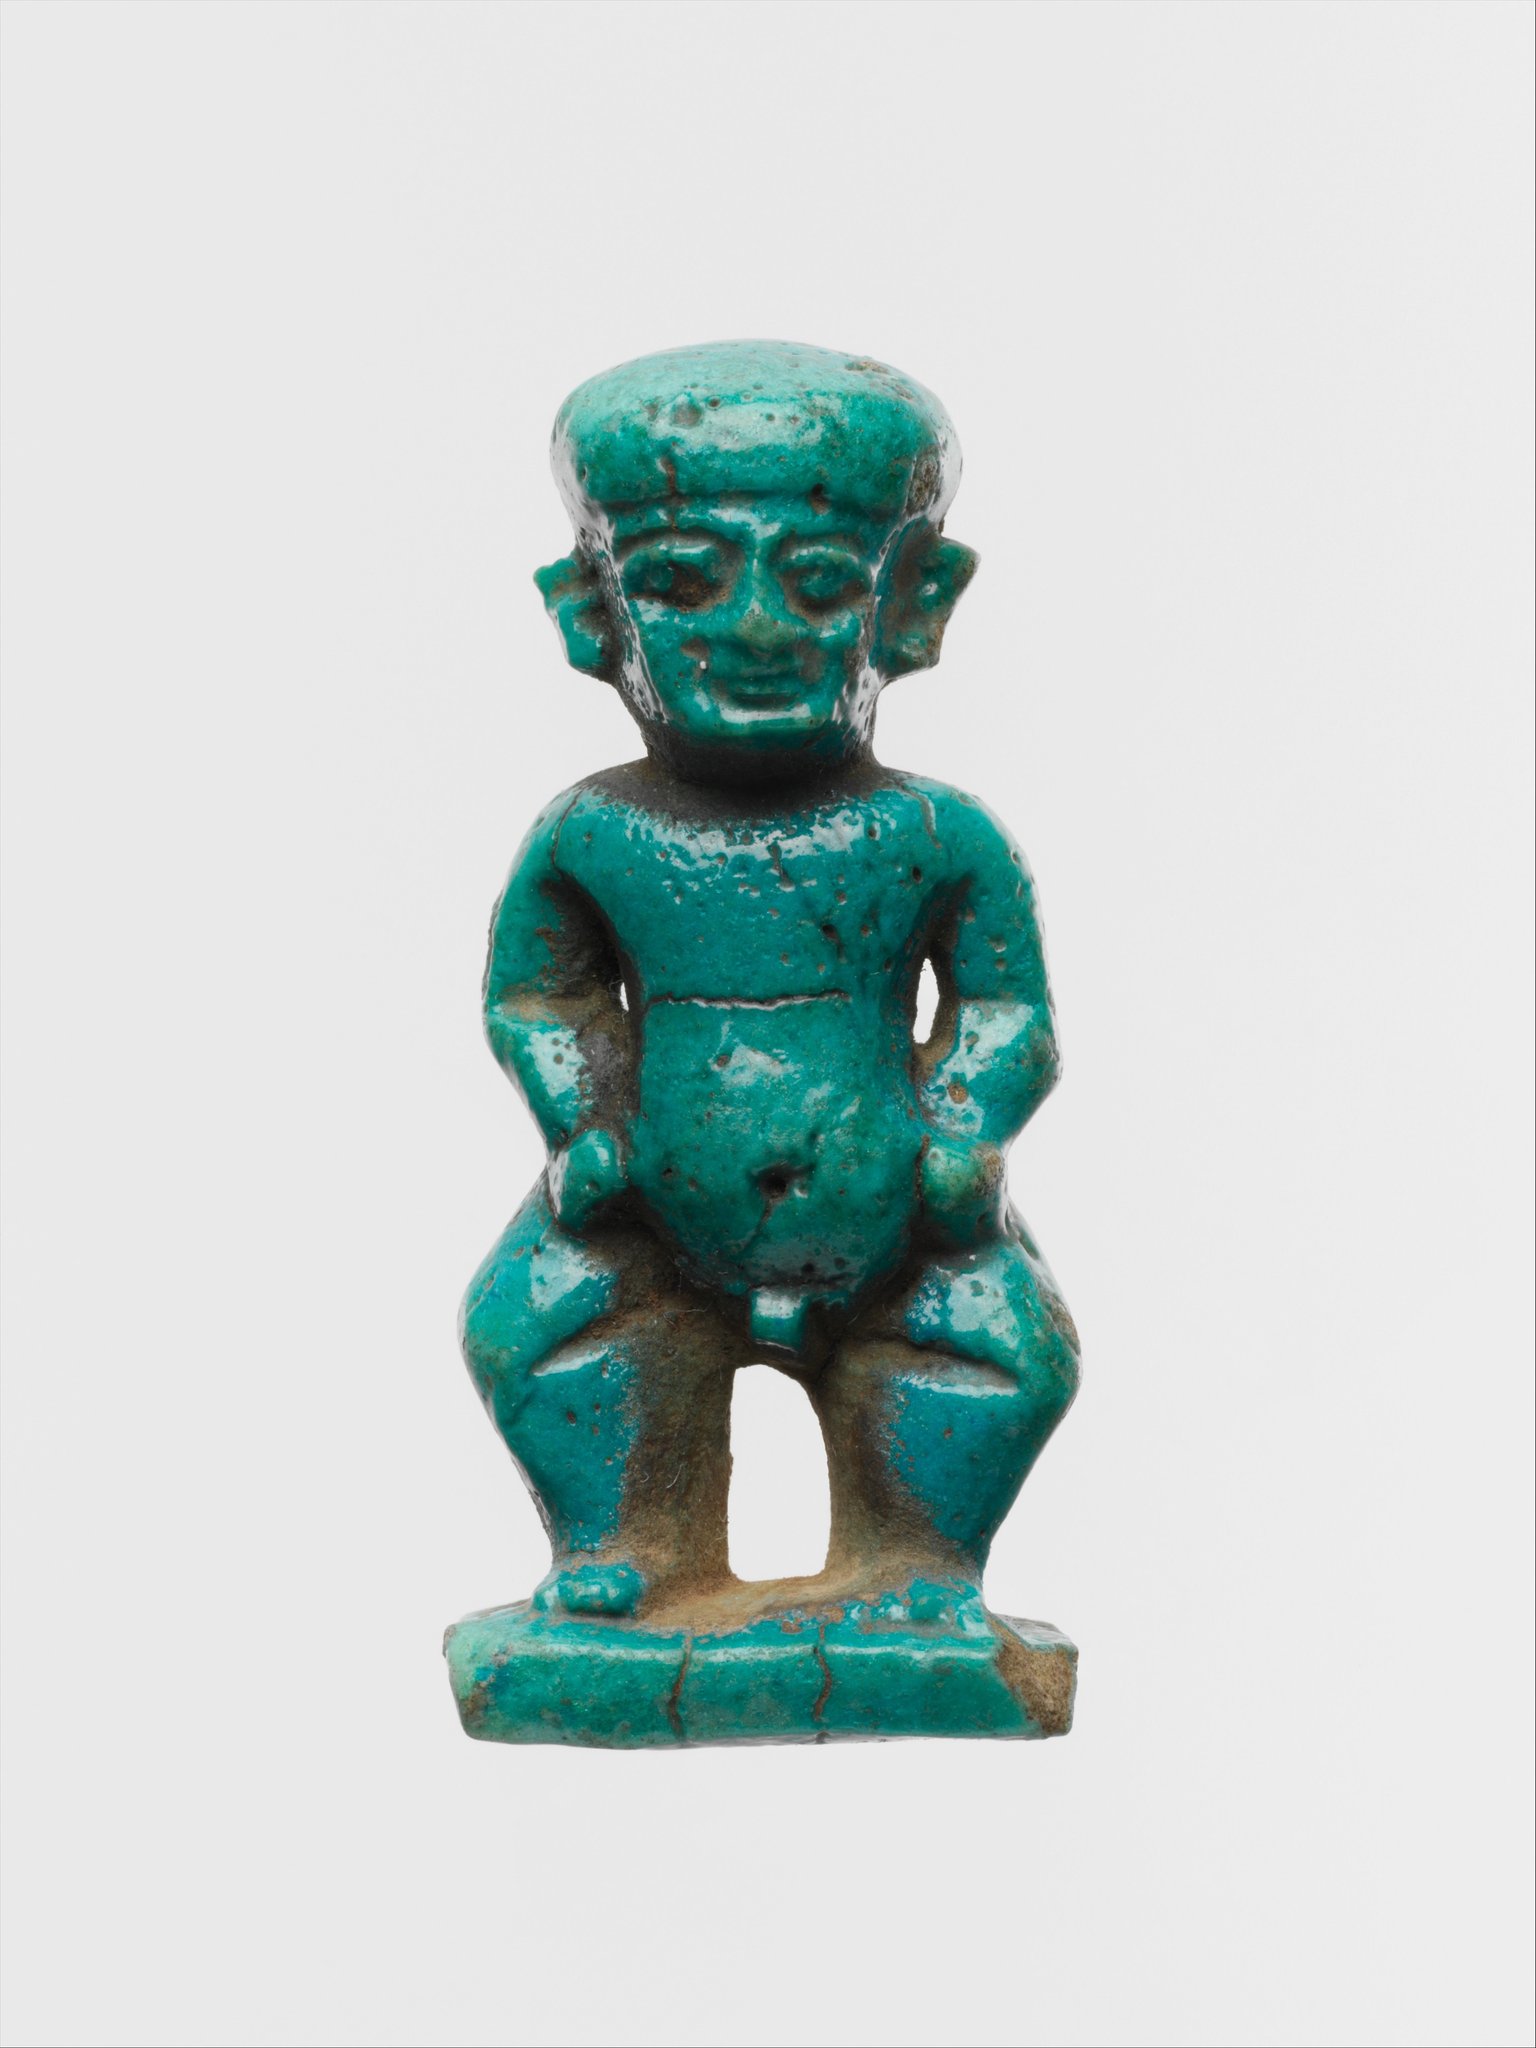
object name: amulet, ptah seker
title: Faience amulet in the form of the dwarf god Pataikos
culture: egyptian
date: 1090-900 BCE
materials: faience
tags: male nudes,gods